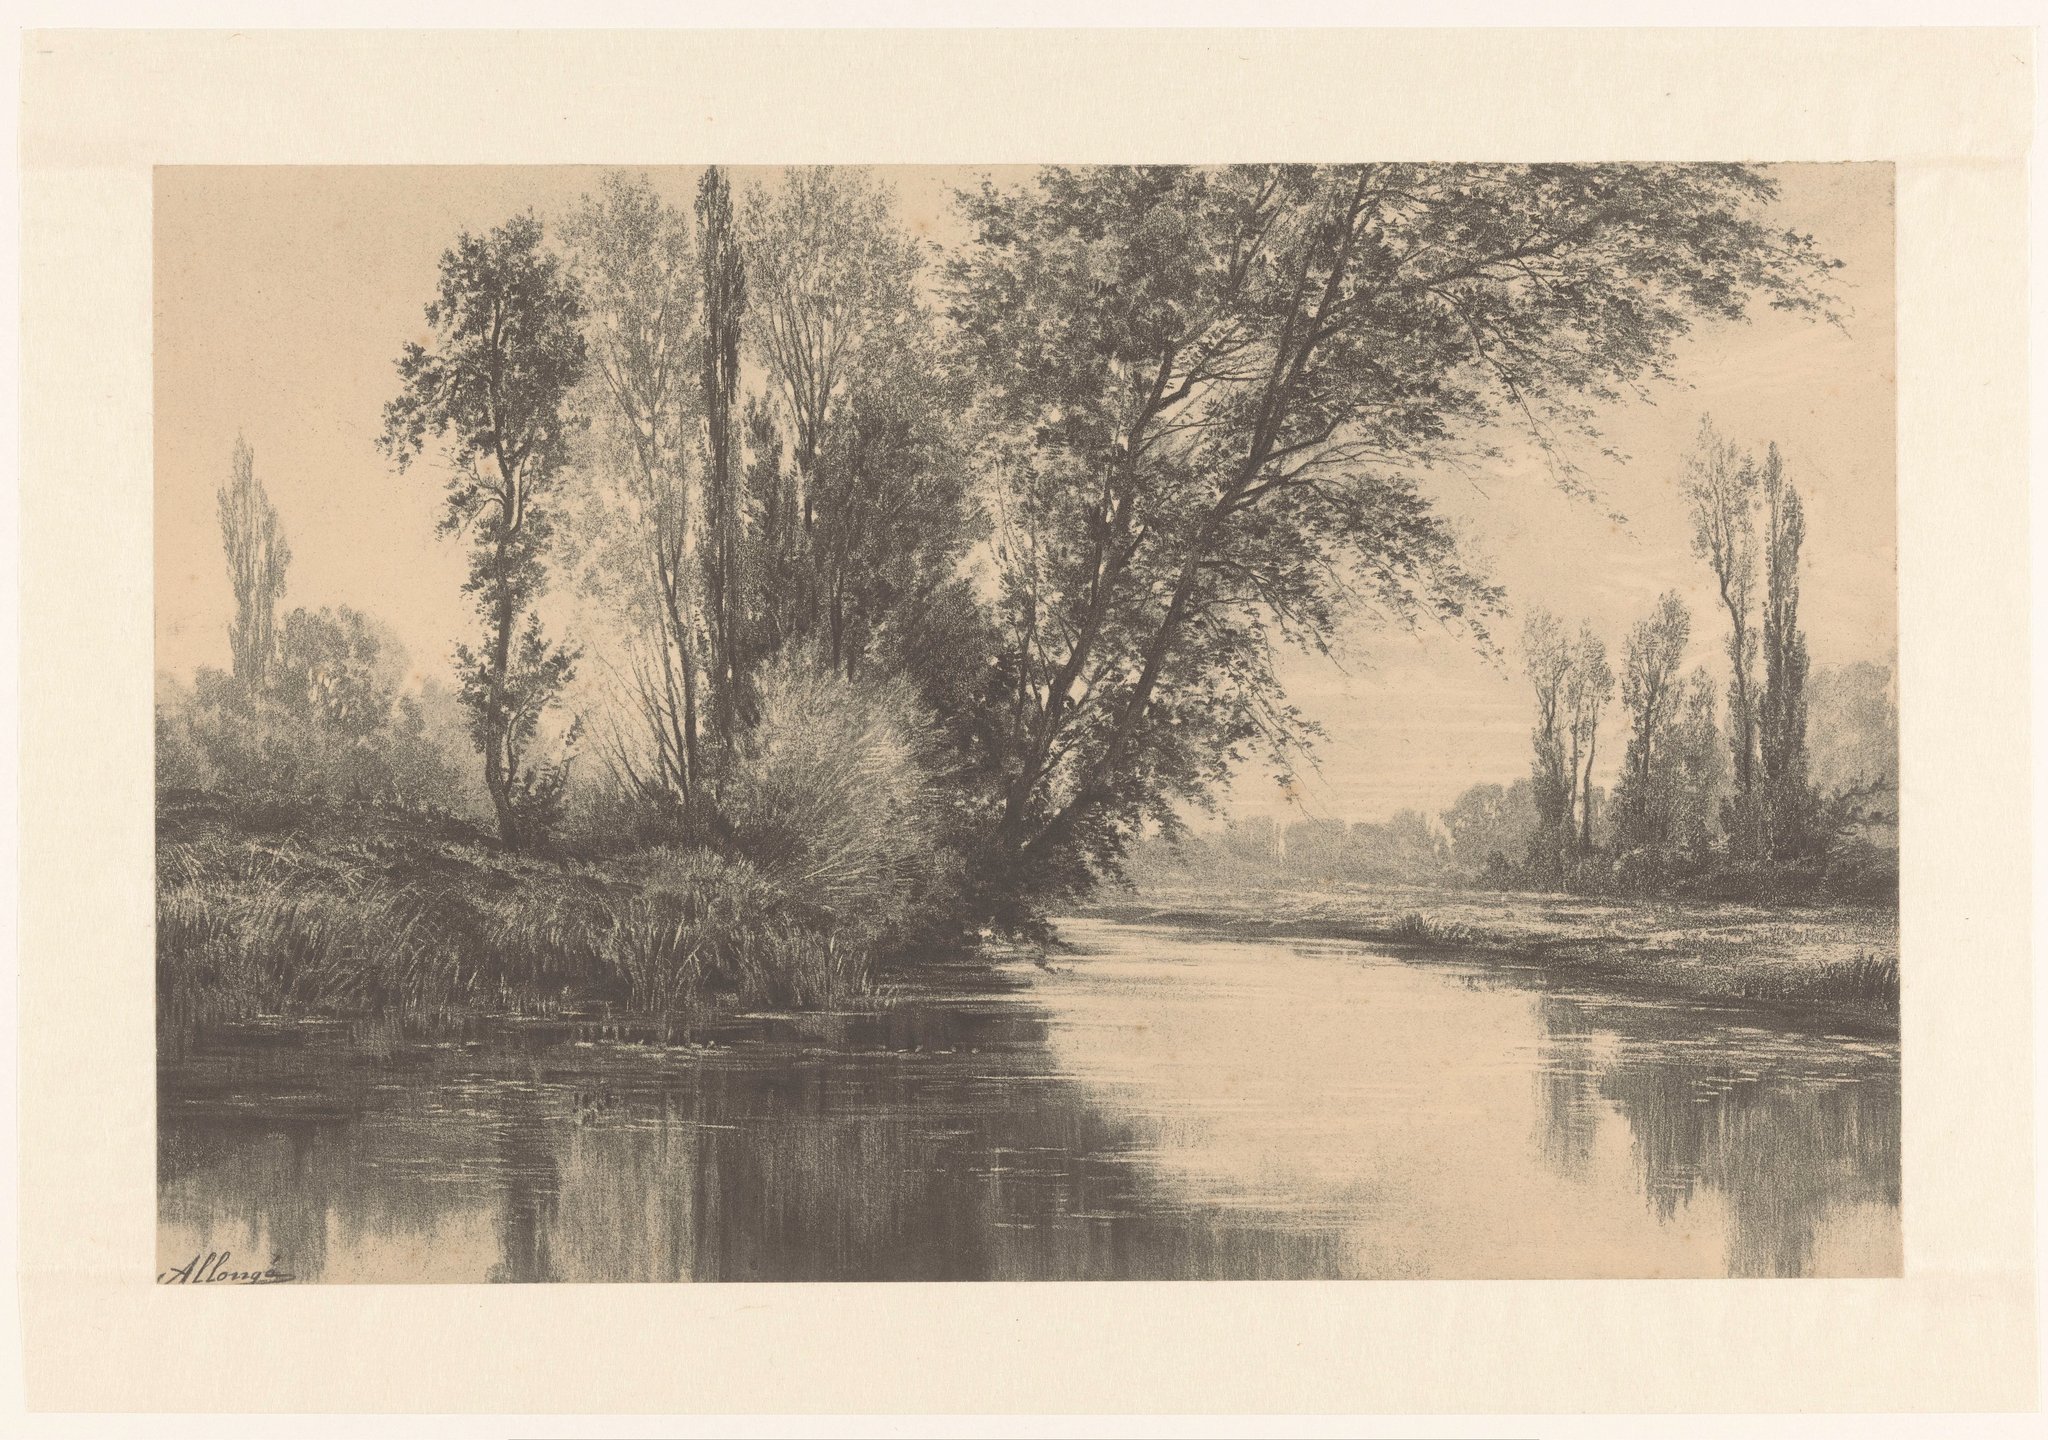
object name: print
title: Natuurgezichten in Hyères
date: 1860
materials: paper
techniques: lithography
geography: paris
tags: trees, river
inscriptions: collector's mark: Lugt 2228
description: Een rivier met oevers en een overhellende boom.